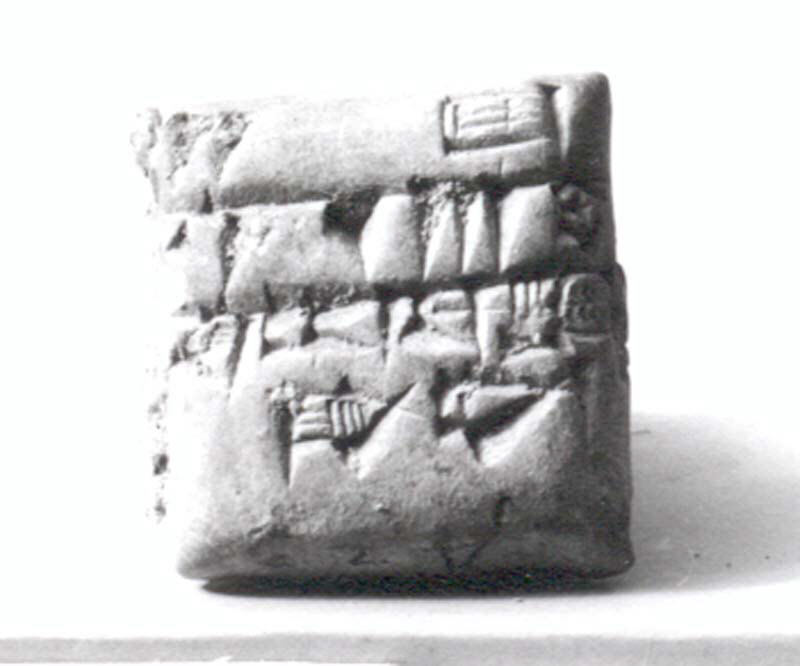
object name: cuneiform tablet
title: Cuneiform tablet: receipt of two lambs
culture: neo-sumerian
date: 2038 BCE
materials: clay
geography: mesopotamia